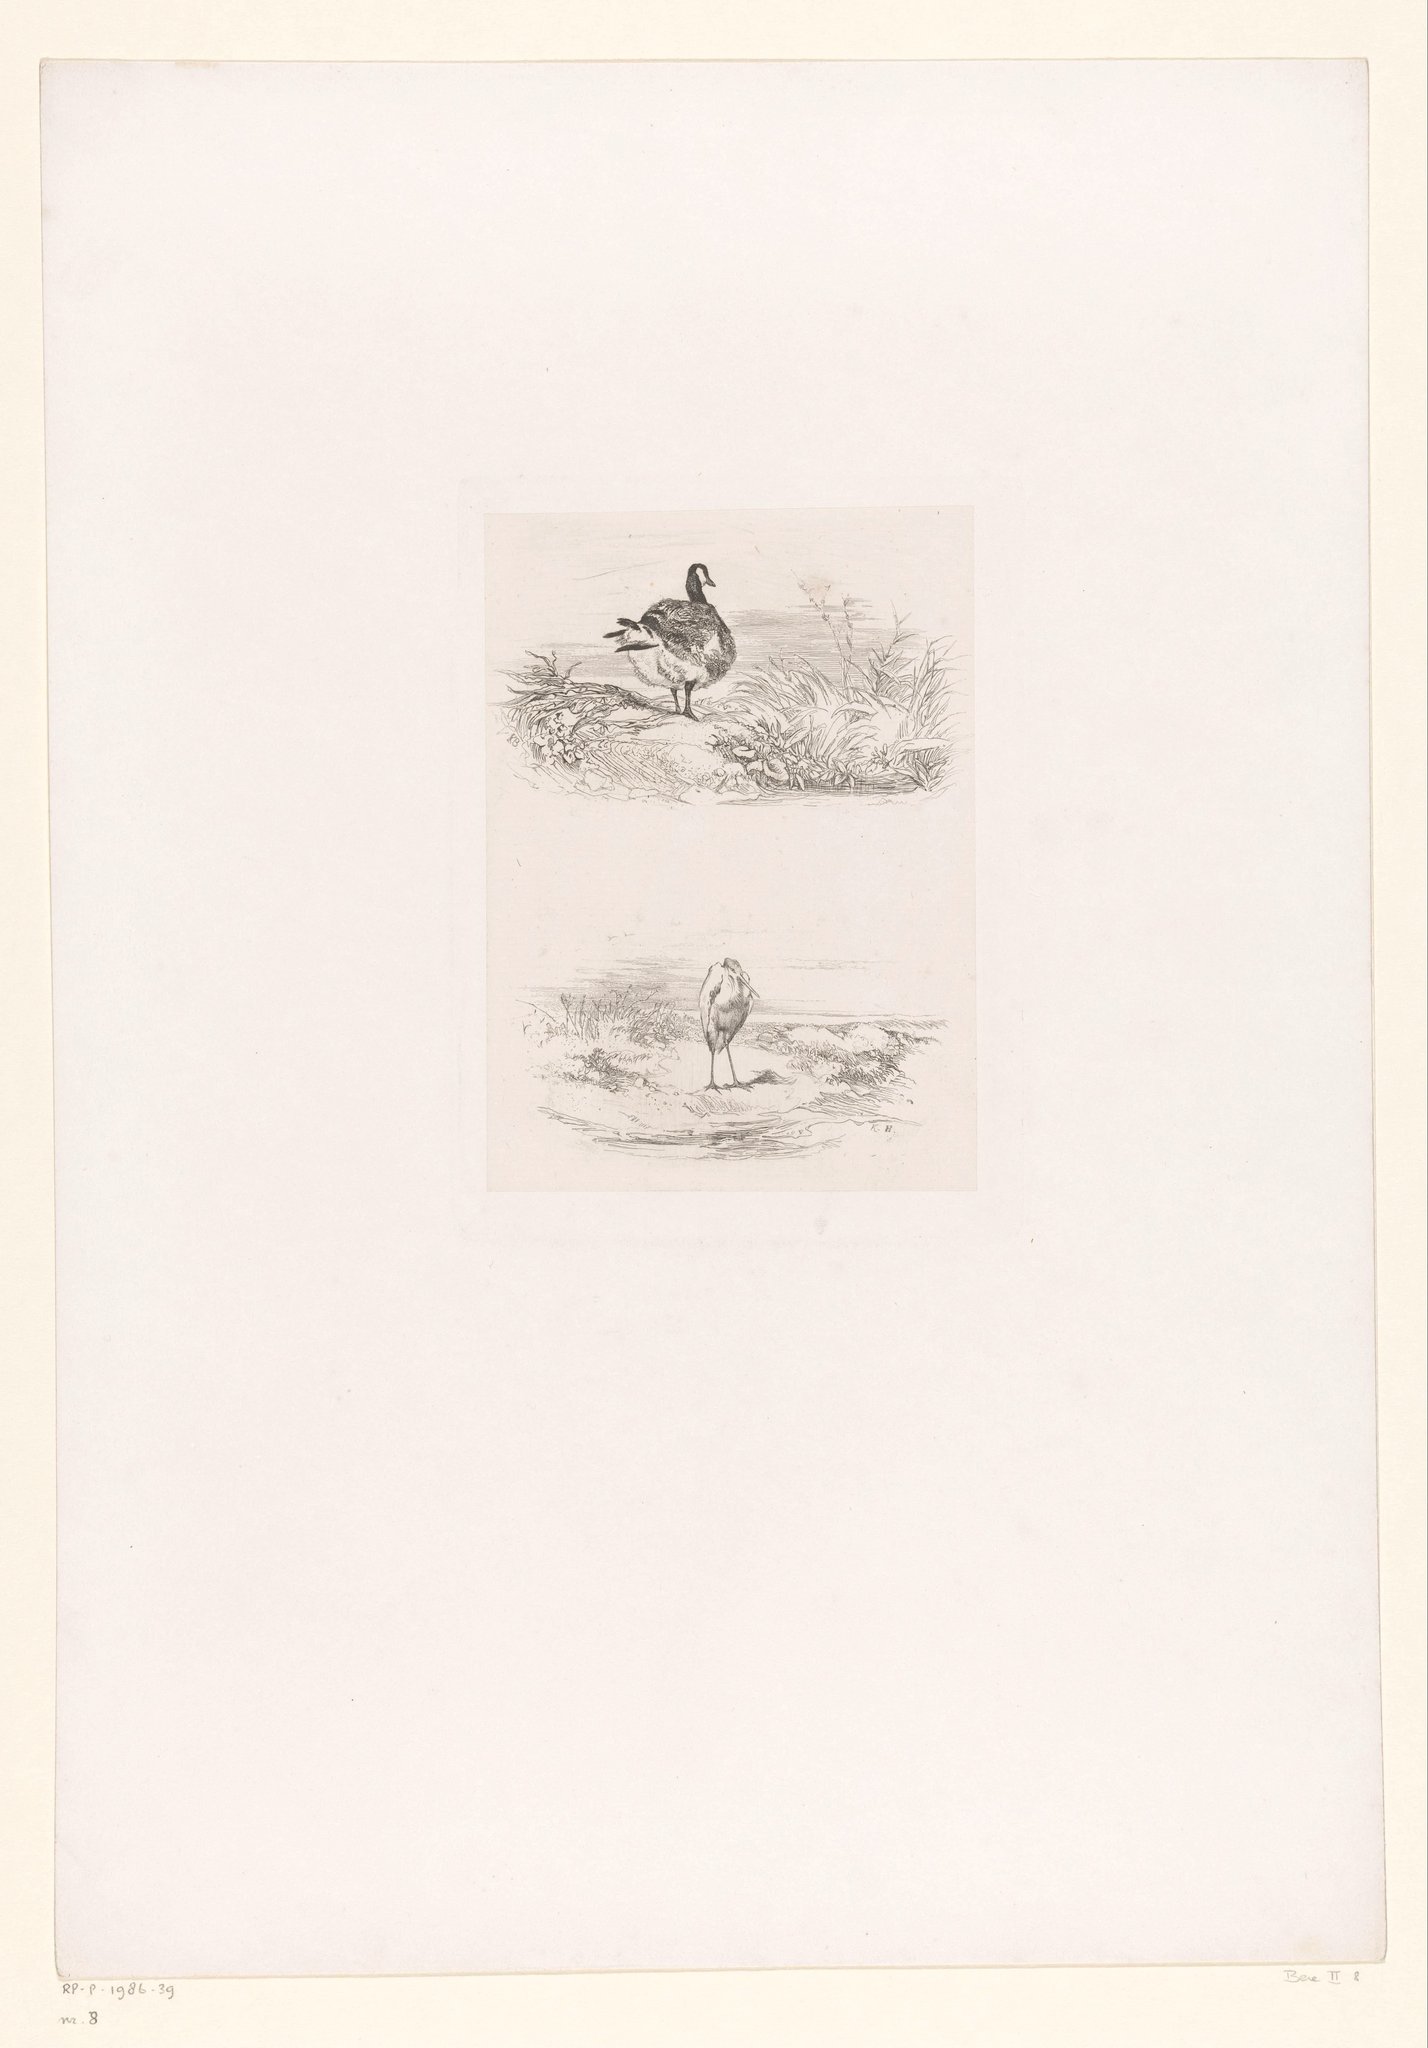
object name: print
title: Eend en een reiger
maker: karl bodmer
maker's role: draughtsman, painter, print maker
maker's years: 1809-1893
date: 1847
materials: paper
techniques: etching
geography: paris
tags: shore-birds and wading-birds: heron, water-birds: duck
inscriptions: collector's mark: Lugt 2228, collector's mark: Lugt 2228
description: Achtste prent uit een serie bestaand uit twaalf landschappen met dieren. De prenten vormen waarschijnlijk een uitwerking van de tekeningen die Bodmer maakte tijdens een expeditie door Noord-Amerika (1832-1834), onder leiding van prins Maximilian zu Wied-Neuwied.